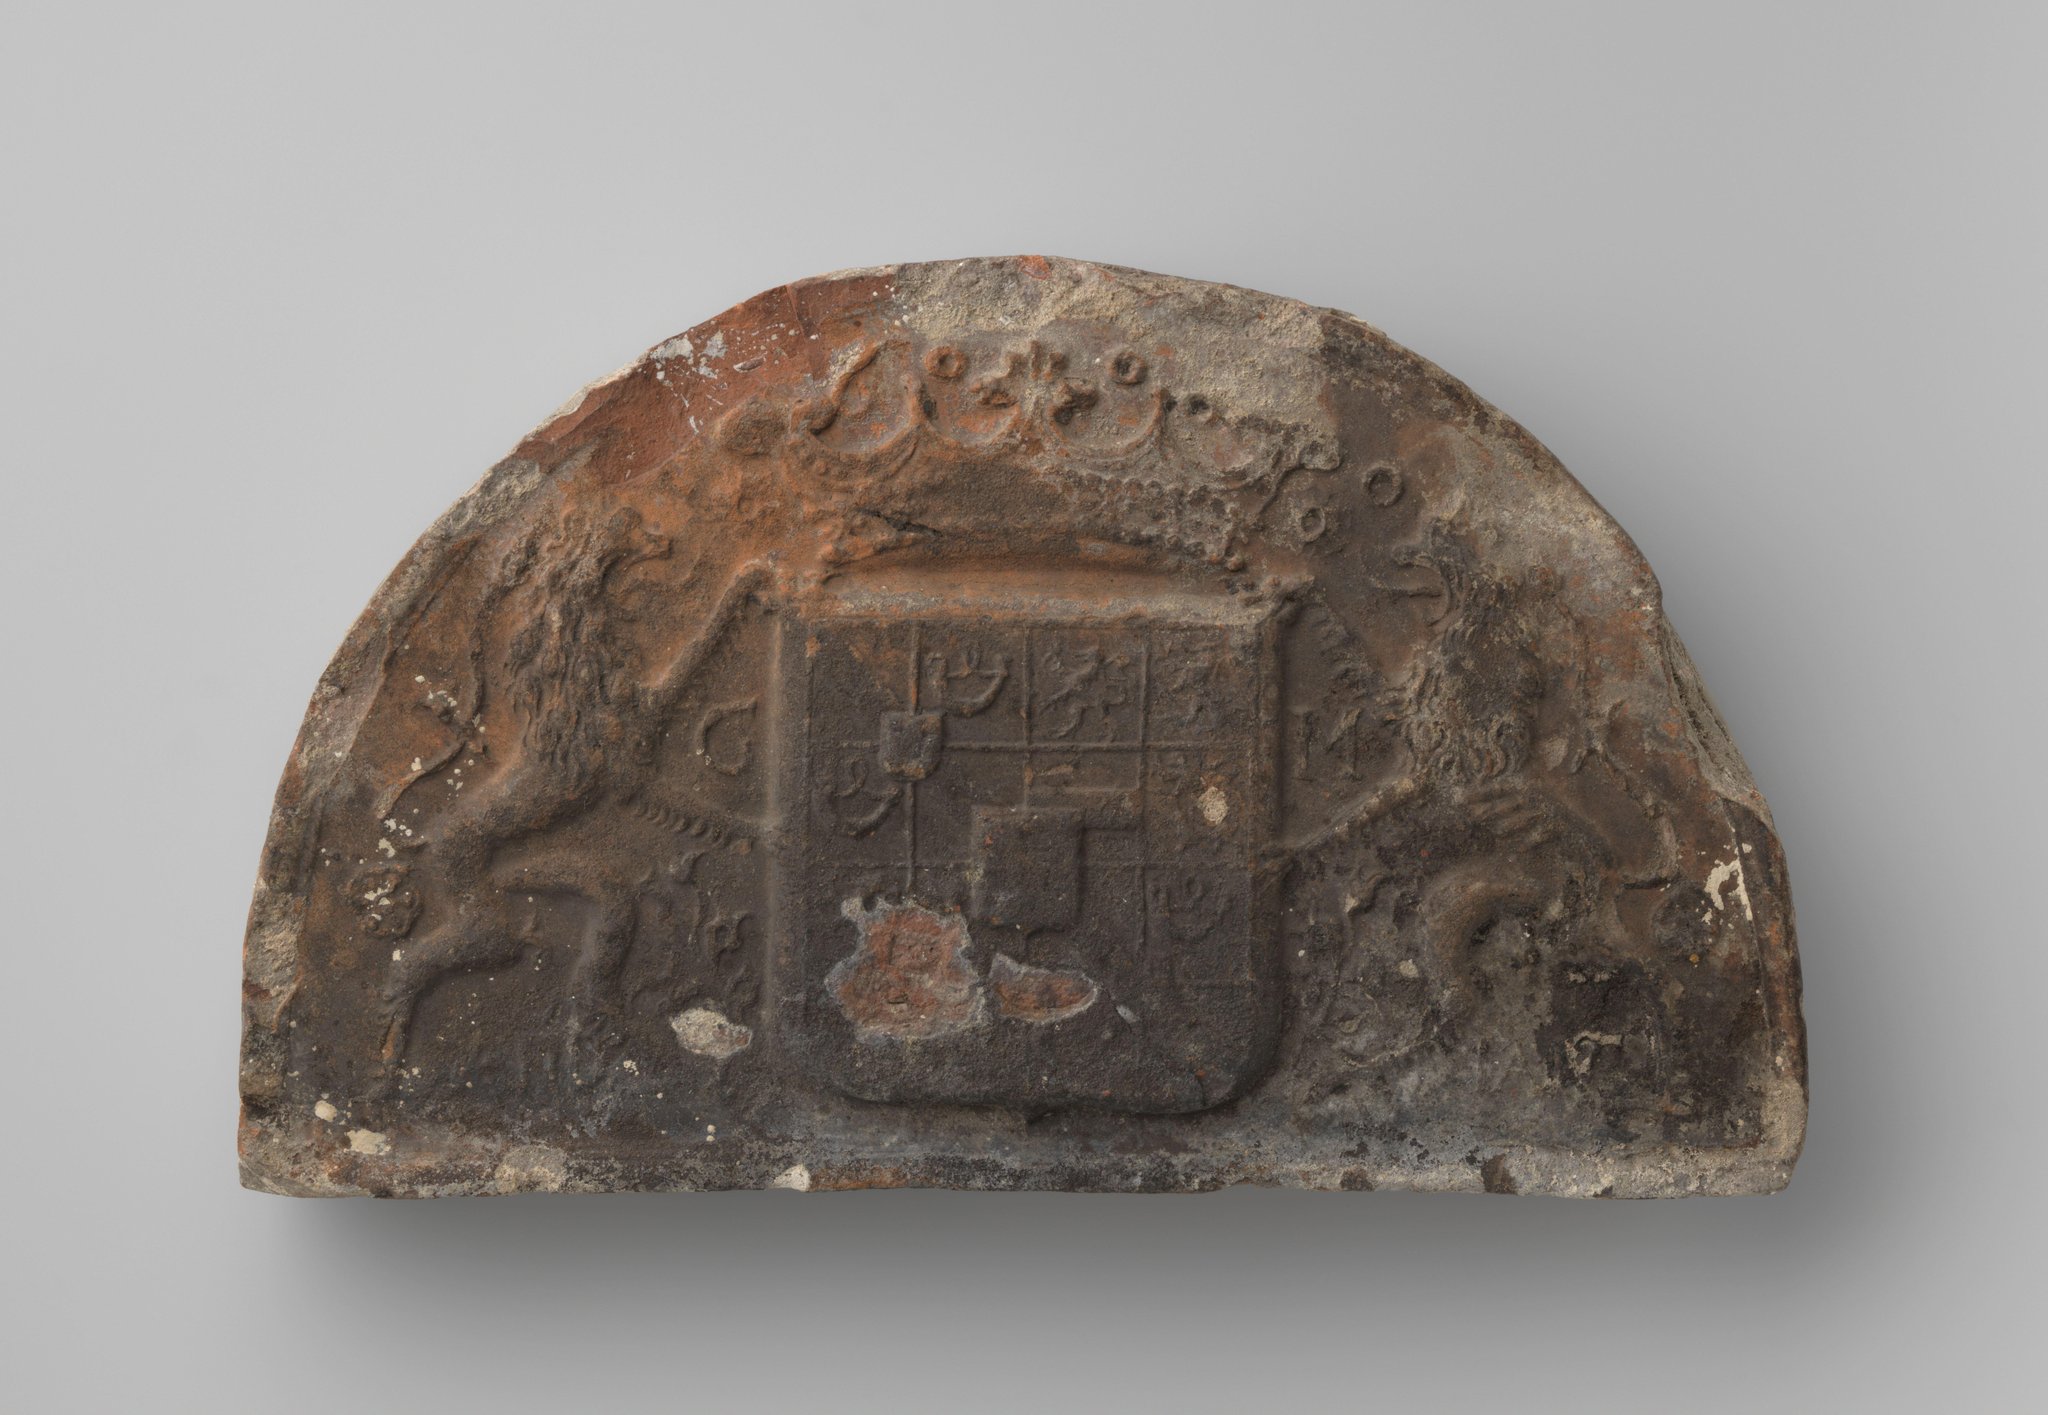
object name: haarddeksteen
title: Haarddeksteen met het wapen van Prins Maurits van Oranje Nassau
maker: Anonymous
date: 1567-1625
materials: earthenware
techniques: printing, firing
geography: netherlands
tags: the hague, maurice (prince of orange)